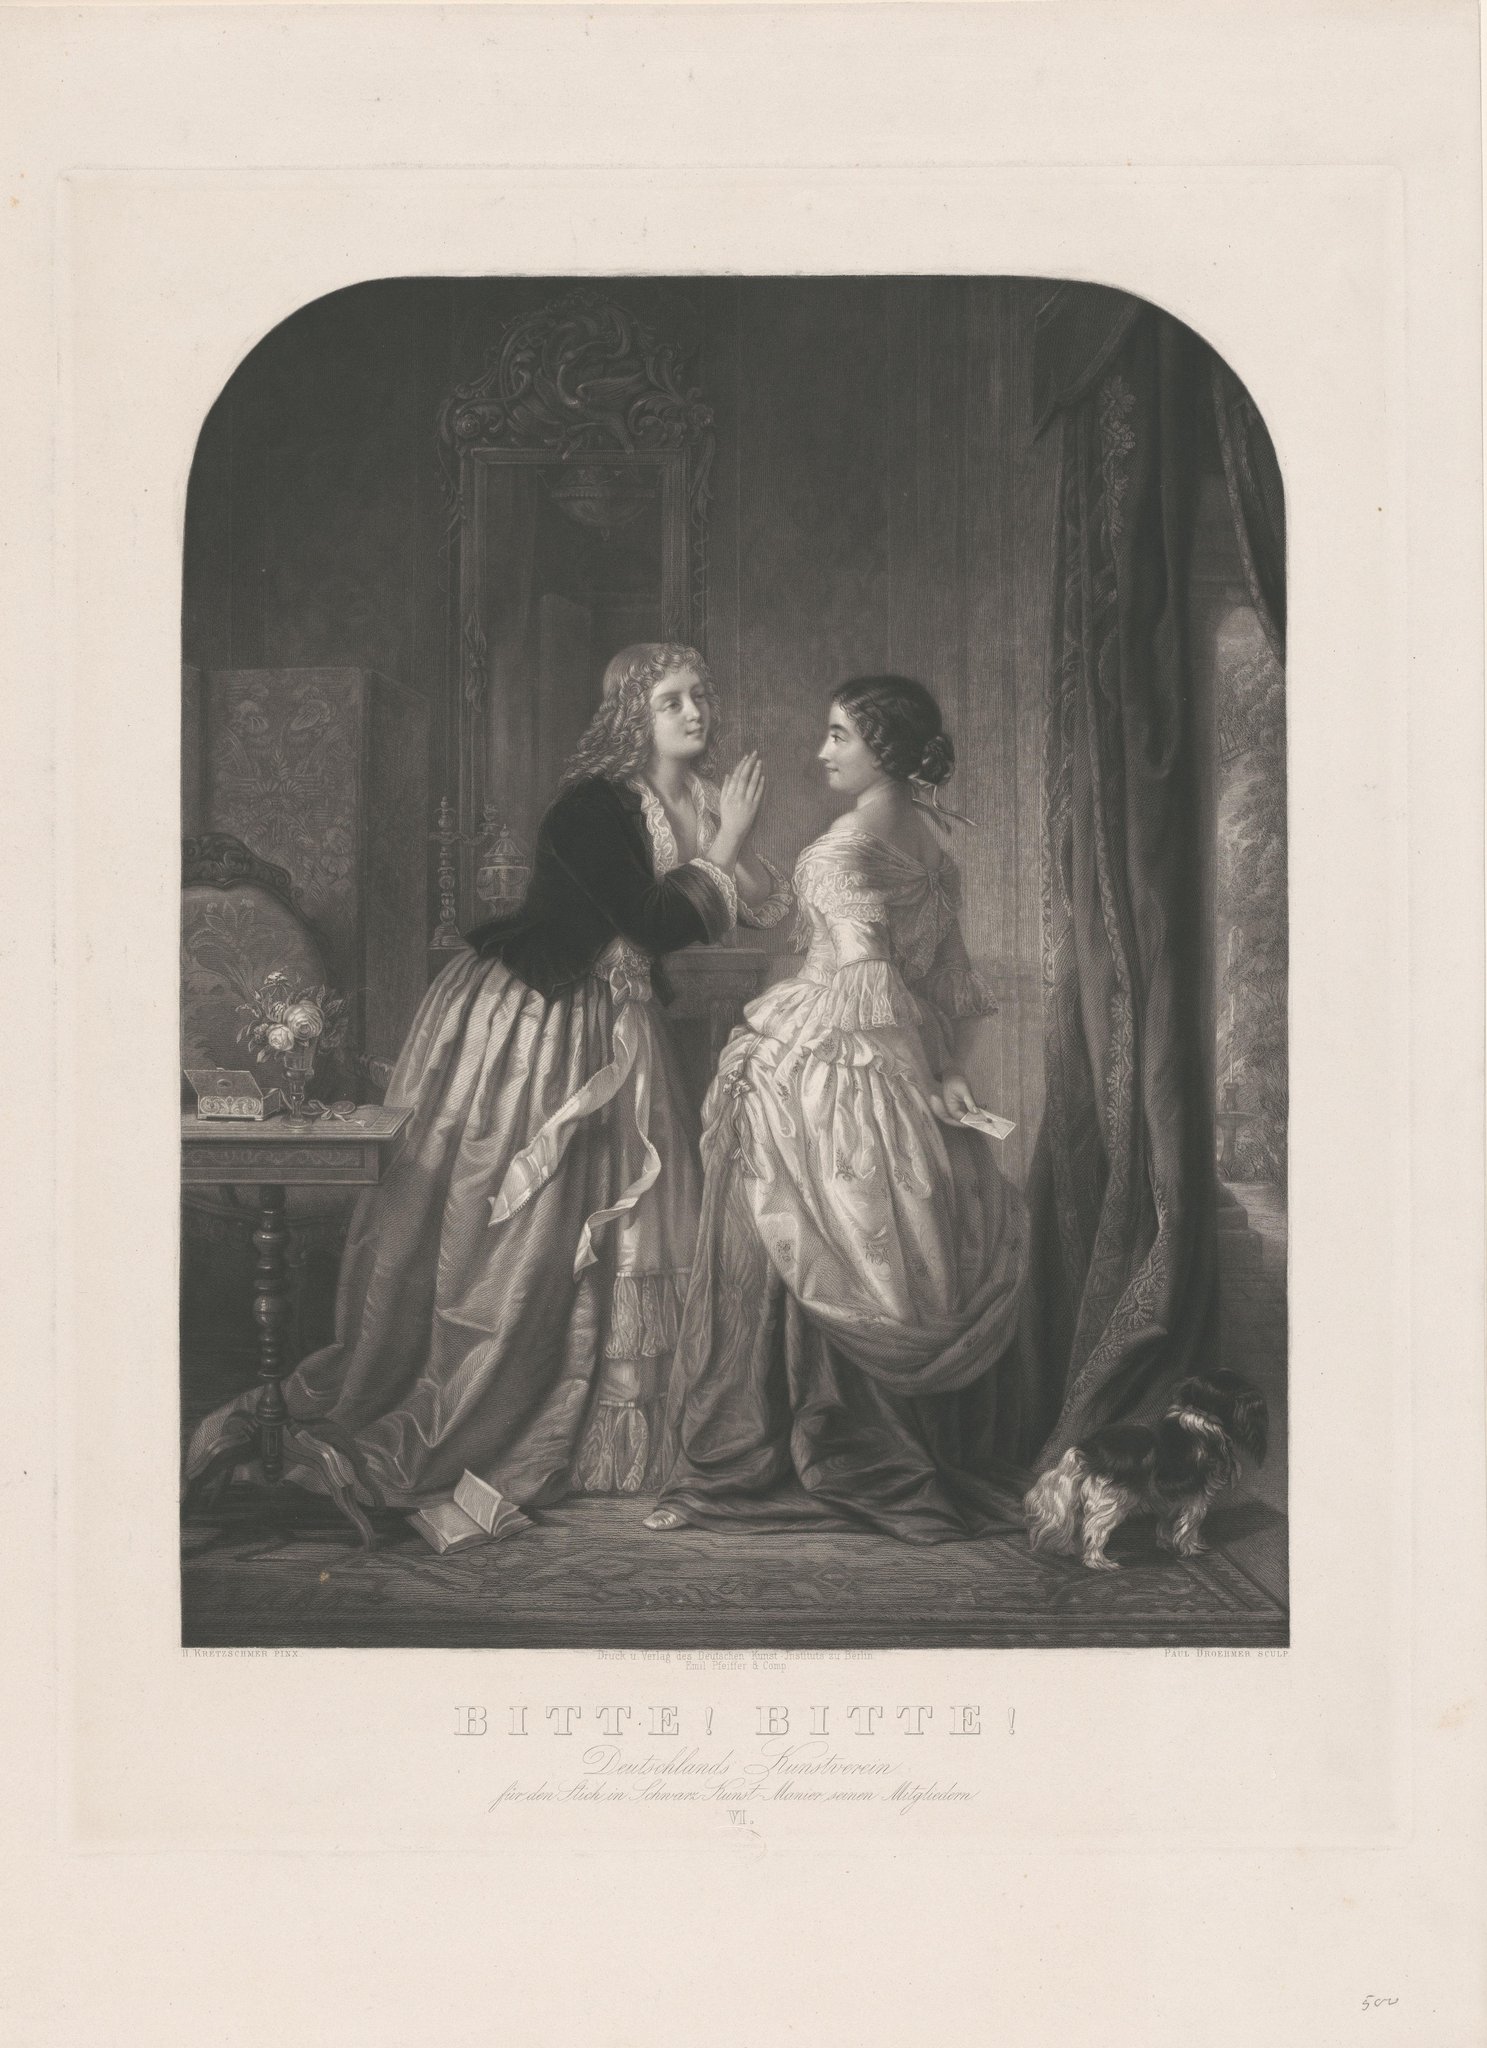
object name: print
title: Twee meisjes met een brief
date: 1843-1886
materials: paper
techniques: etching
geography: berlin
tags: lover with love-letter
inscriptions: collector's mark: Lugt 2228